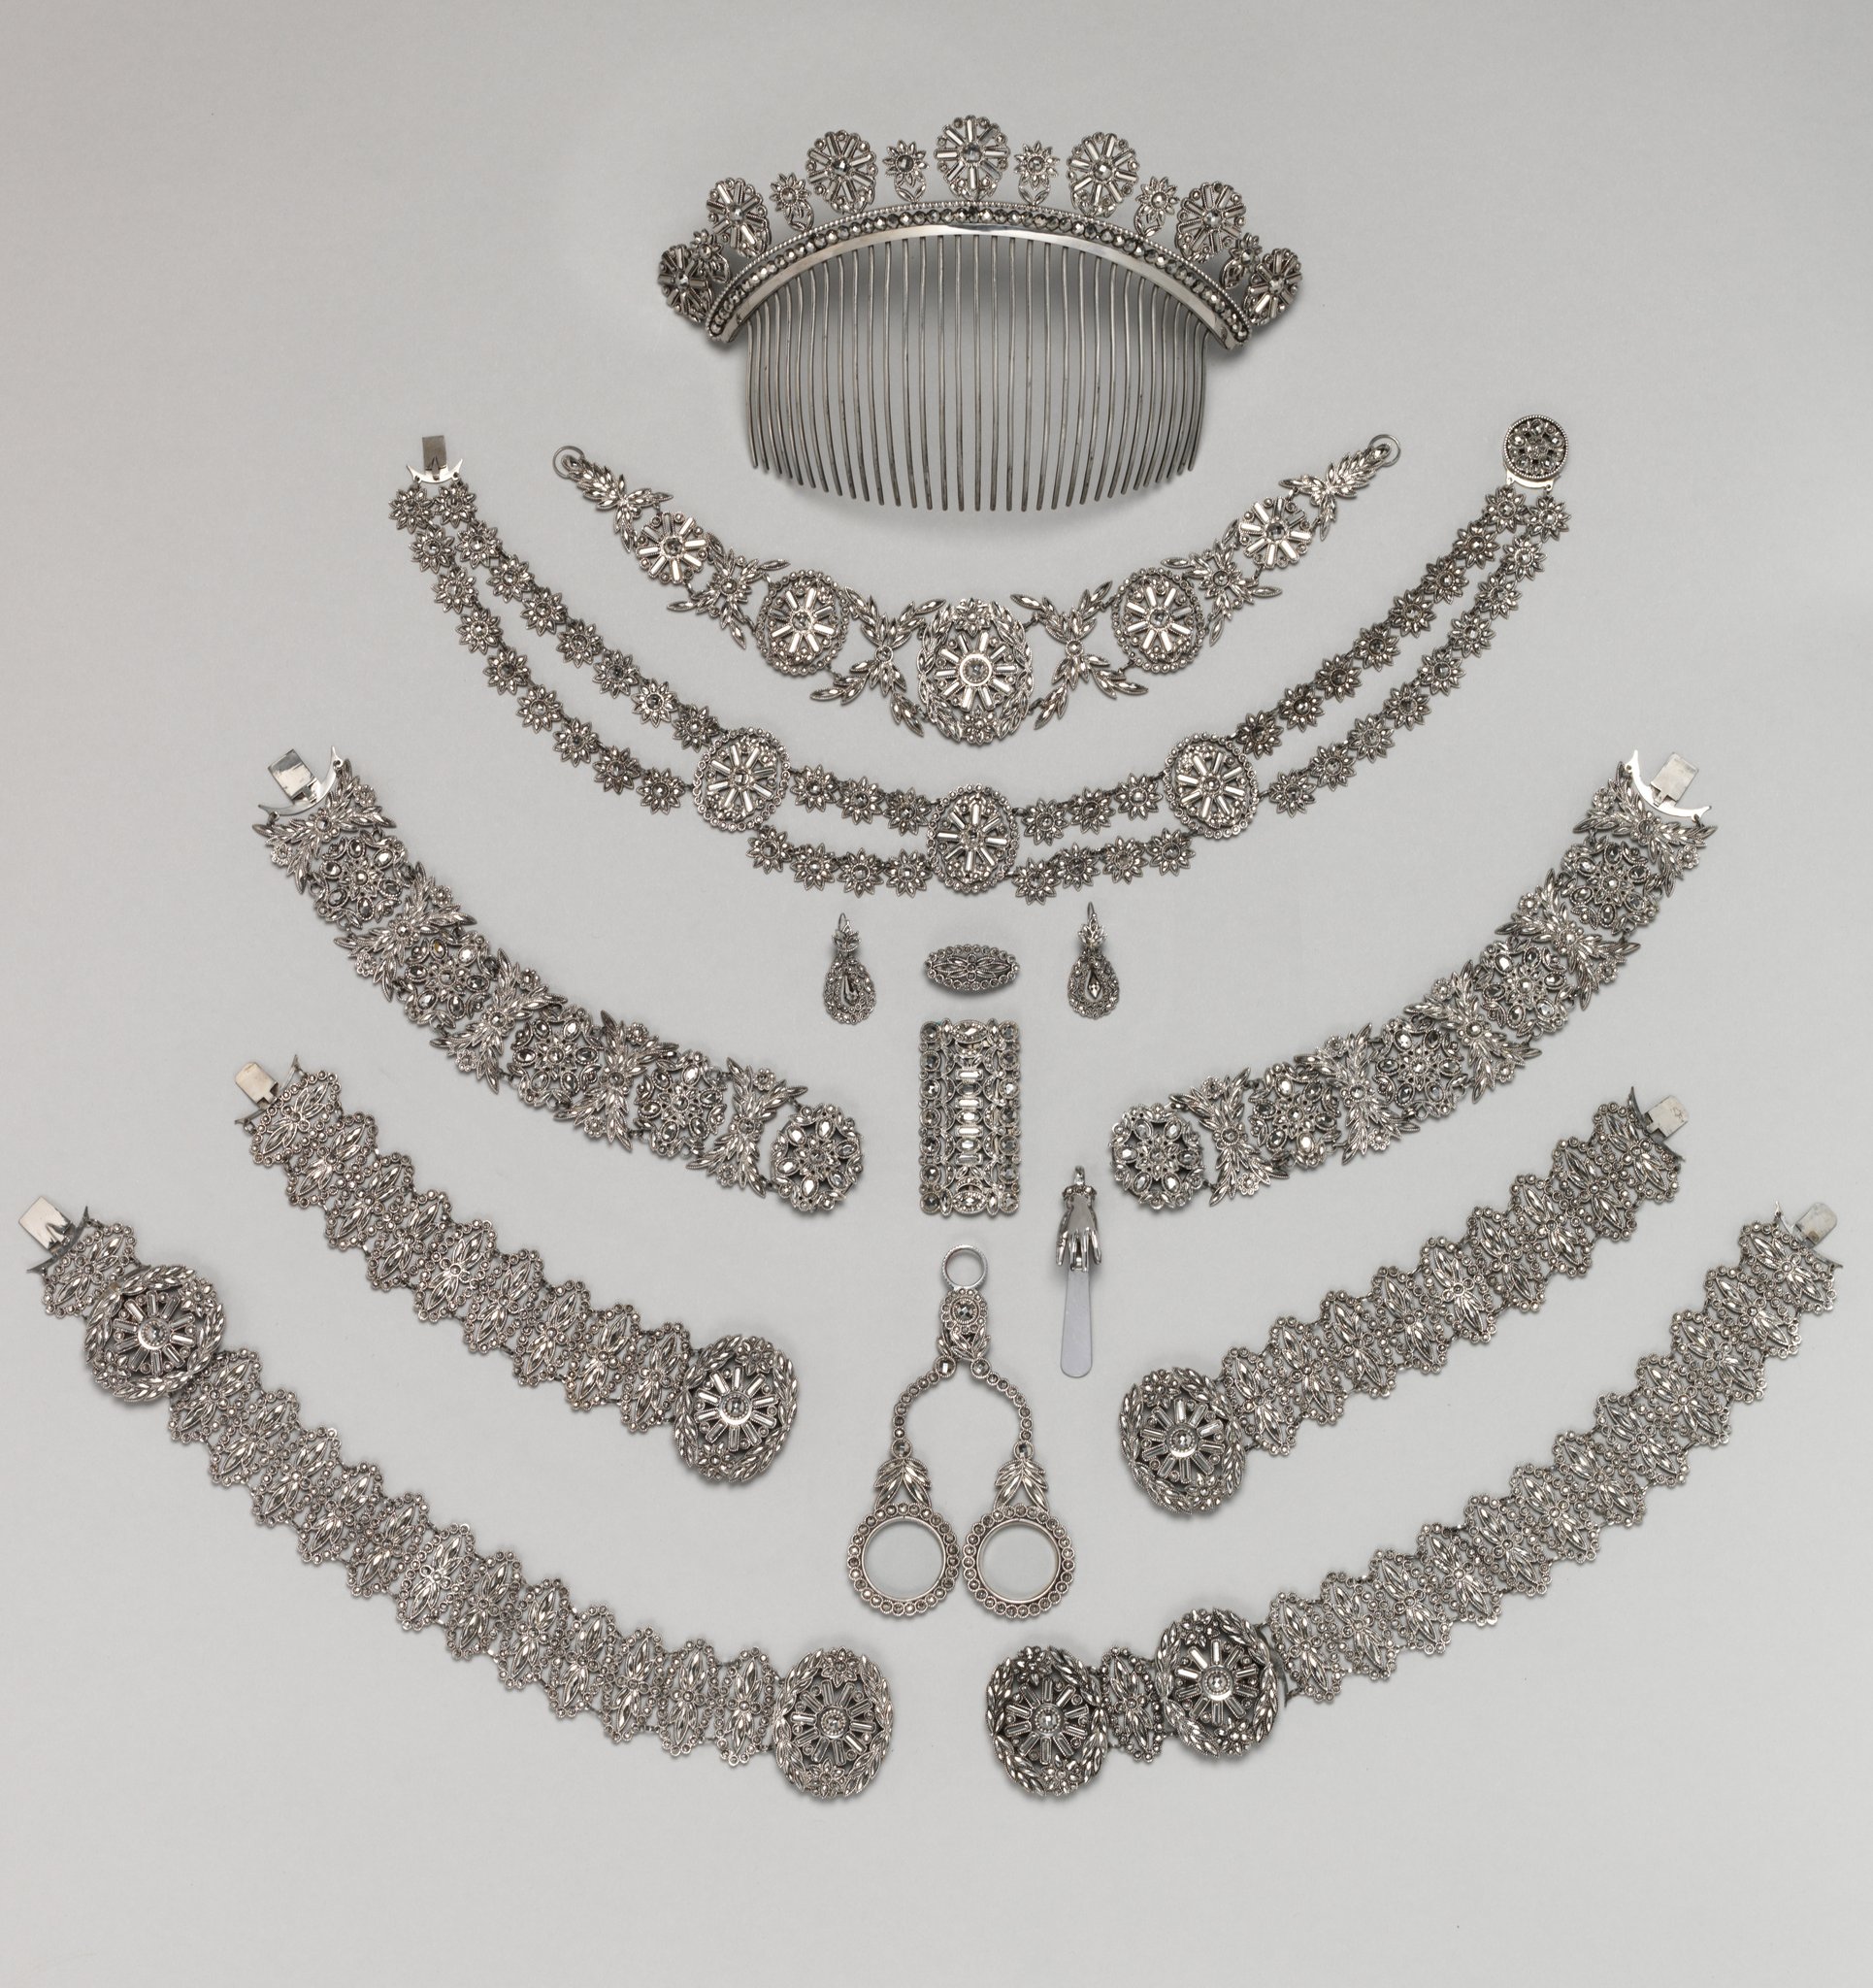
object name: parure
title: Fifteen-piece parure in leather case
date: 1810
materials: gilt, leather, steel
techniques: cutting, stamping